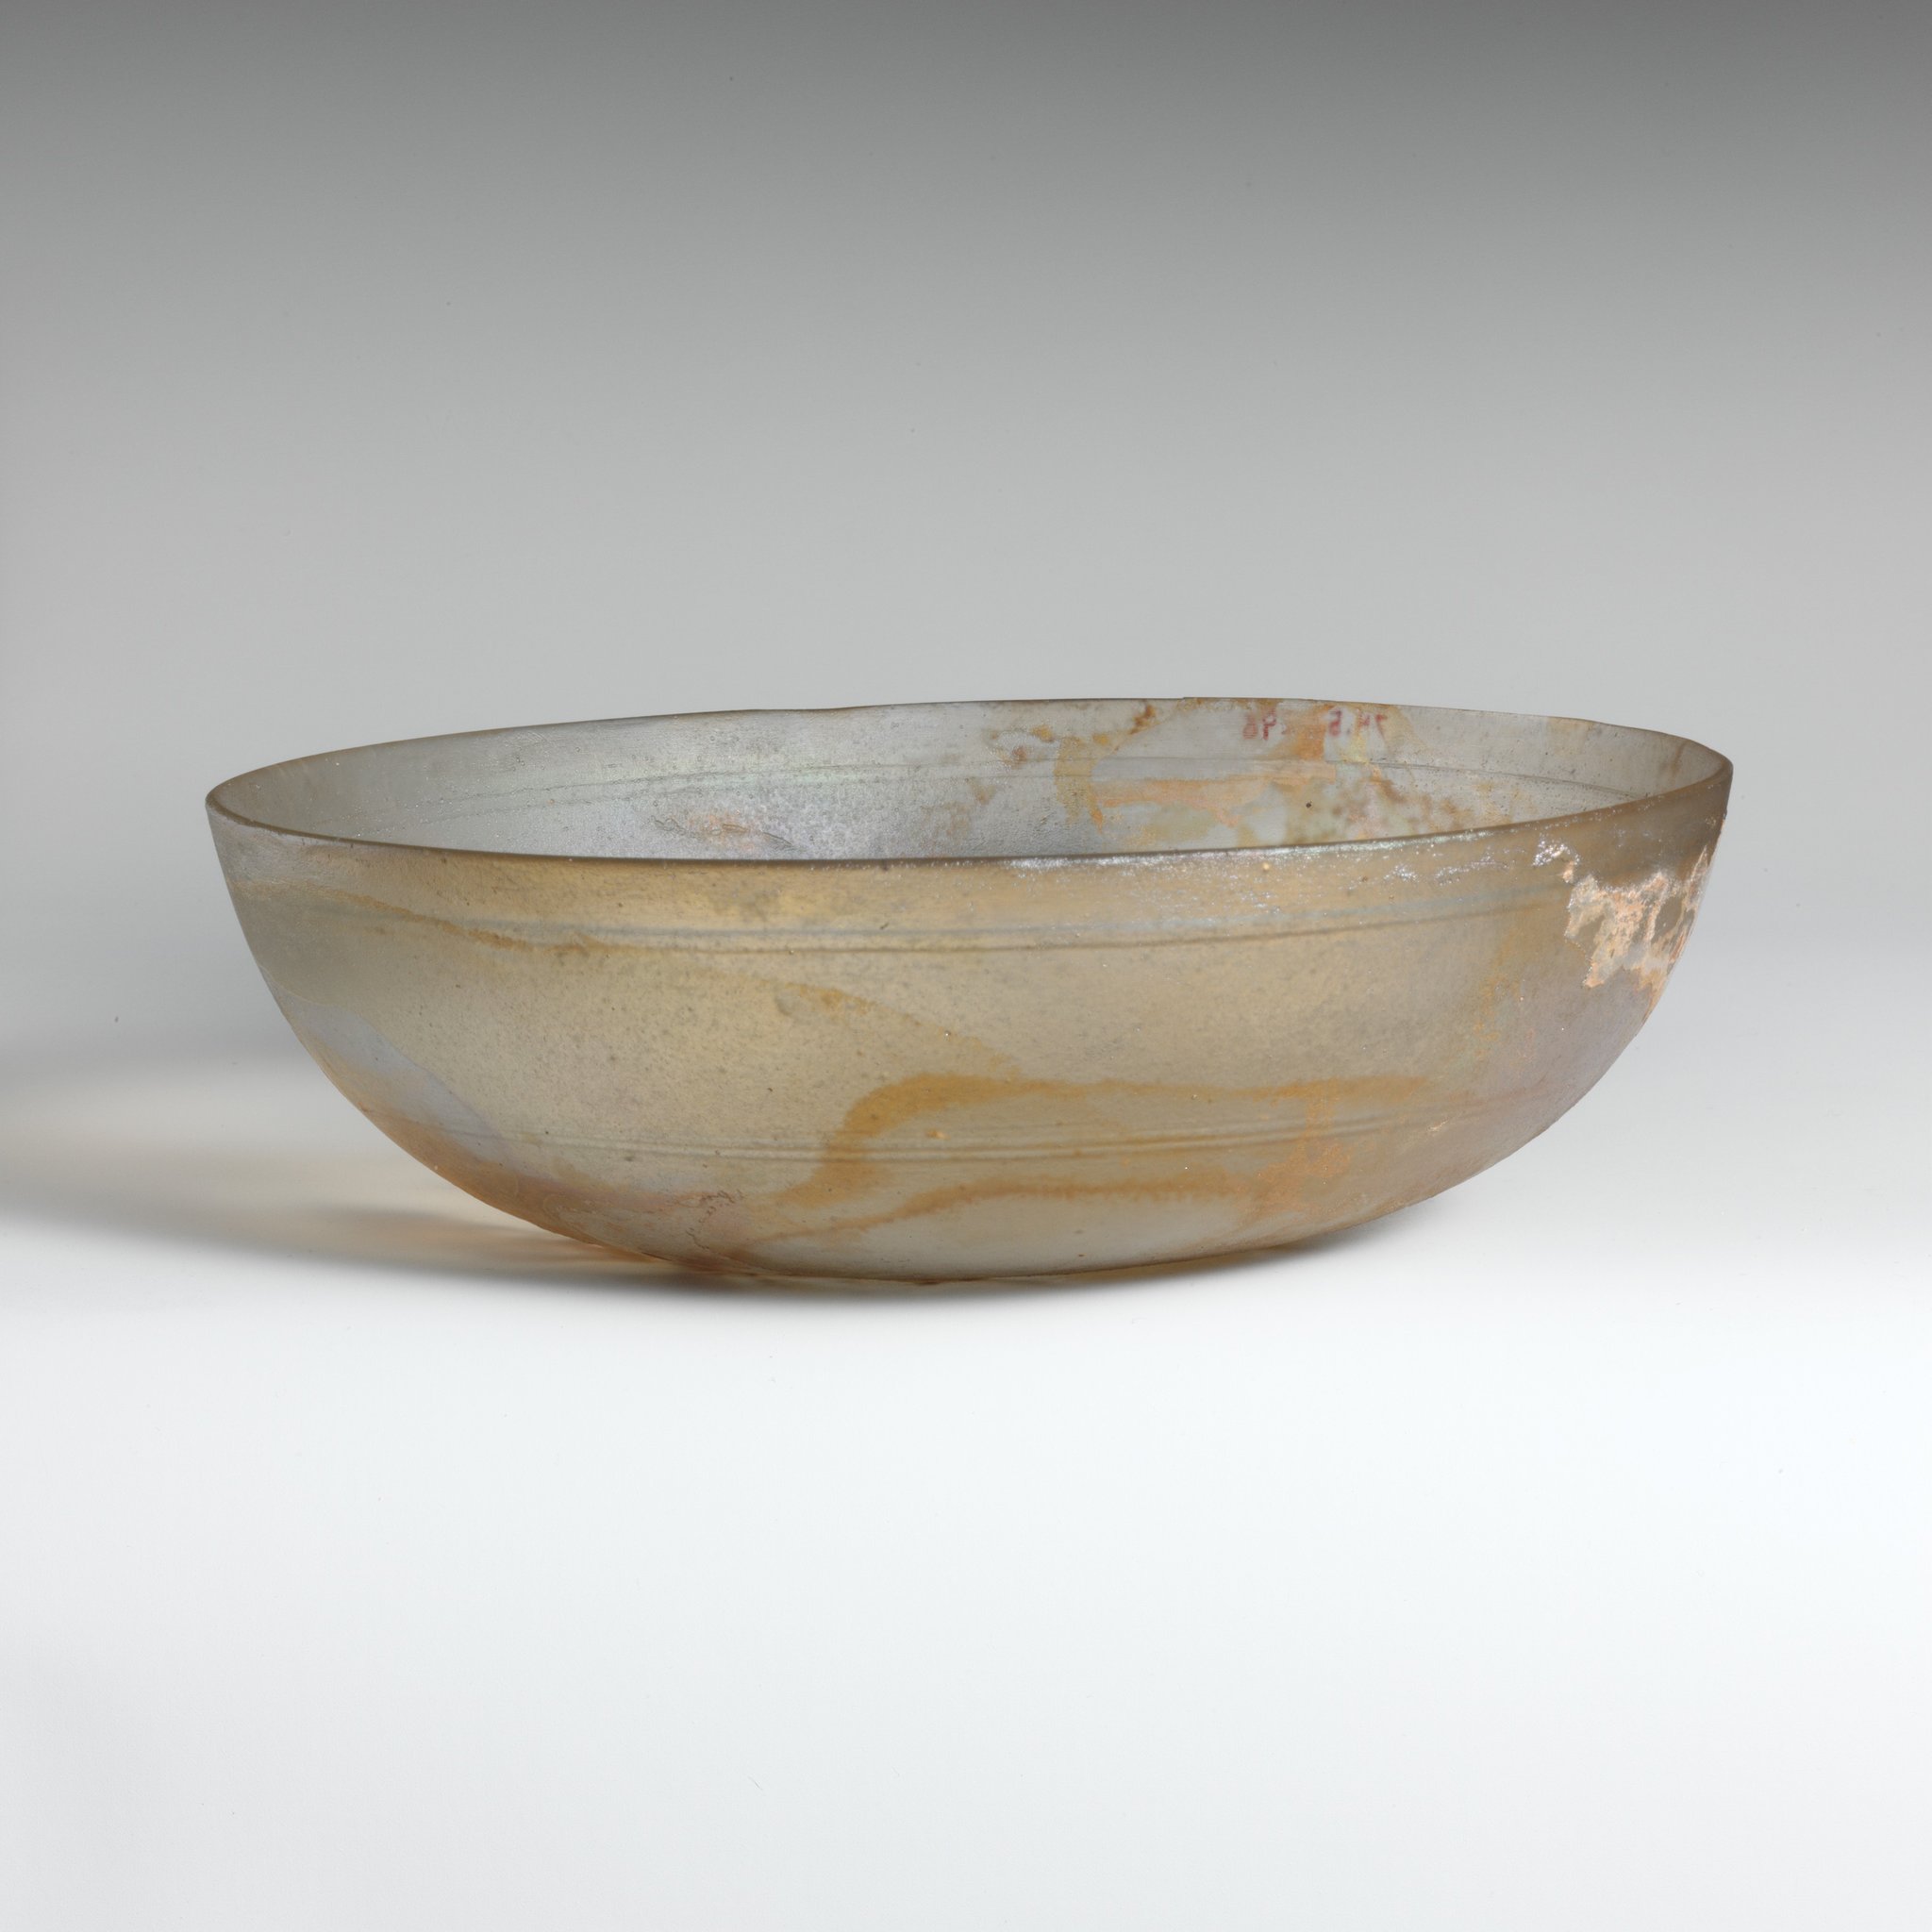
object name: bowl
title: Glass bowl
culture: roman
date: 34 BCE-33 CE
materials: glass